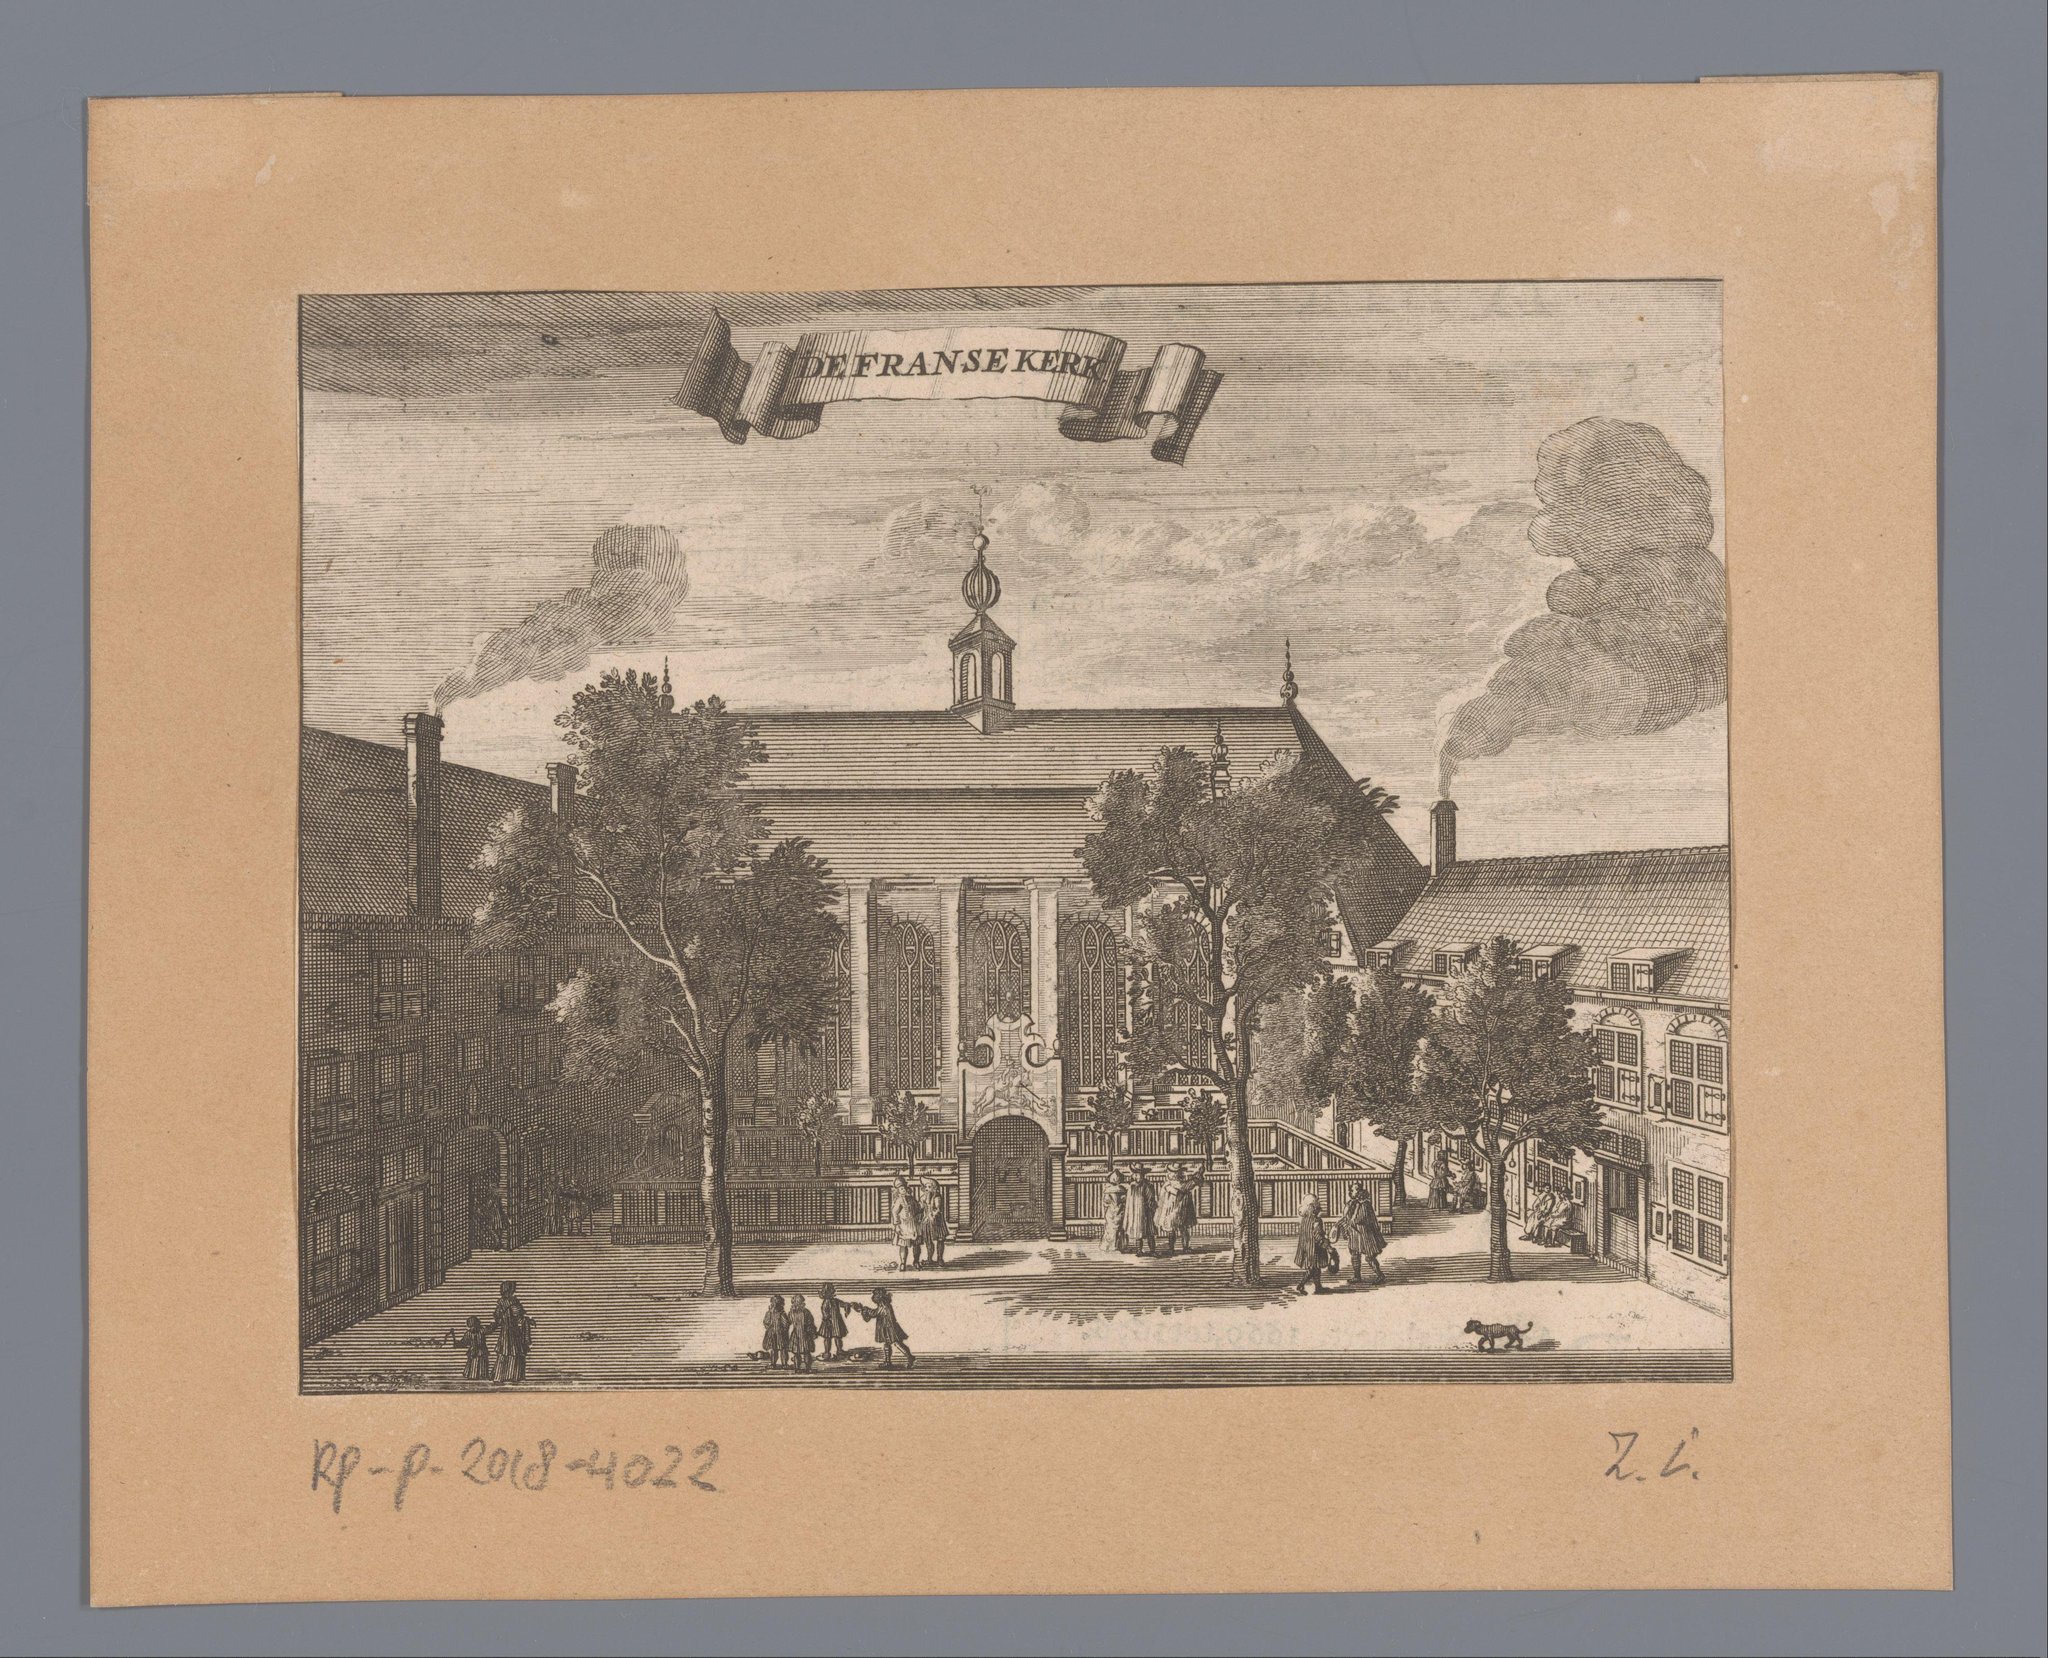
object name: book illustration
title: Gezicht op de Waalse Kerk en het Sint-Jorishof te Amsterdam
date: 1726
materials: paper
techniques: etching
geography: amsterdam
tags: alms-house (dutch: 'hofje'), church (exterior)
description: Prent in deze staat uit: Commelin, Caspar. Beschryvinge van Amsterdam, zynde een naukeurige verhandelinge van desselfs eerste oorspronk uyt (…). Amsterdam: Andries van Damme et al., 1726, p. 480. Eerdere staat gebruikt in: Commelin, Caspar. Beschryvinge van Amsterdam, desselfs eerste oorspronk uyt den Huyse (…). Amsterdam: Abraham Wolfgang et al., 1693. En in: Commelin, Caspar. Beschryvinge van Amsterdam, zynde een naukeurige verhandelinge van desselfs eerste oorspronk uyt (…). Amsterdam: weduwe Aart Dircksz Oossaan, 1694.